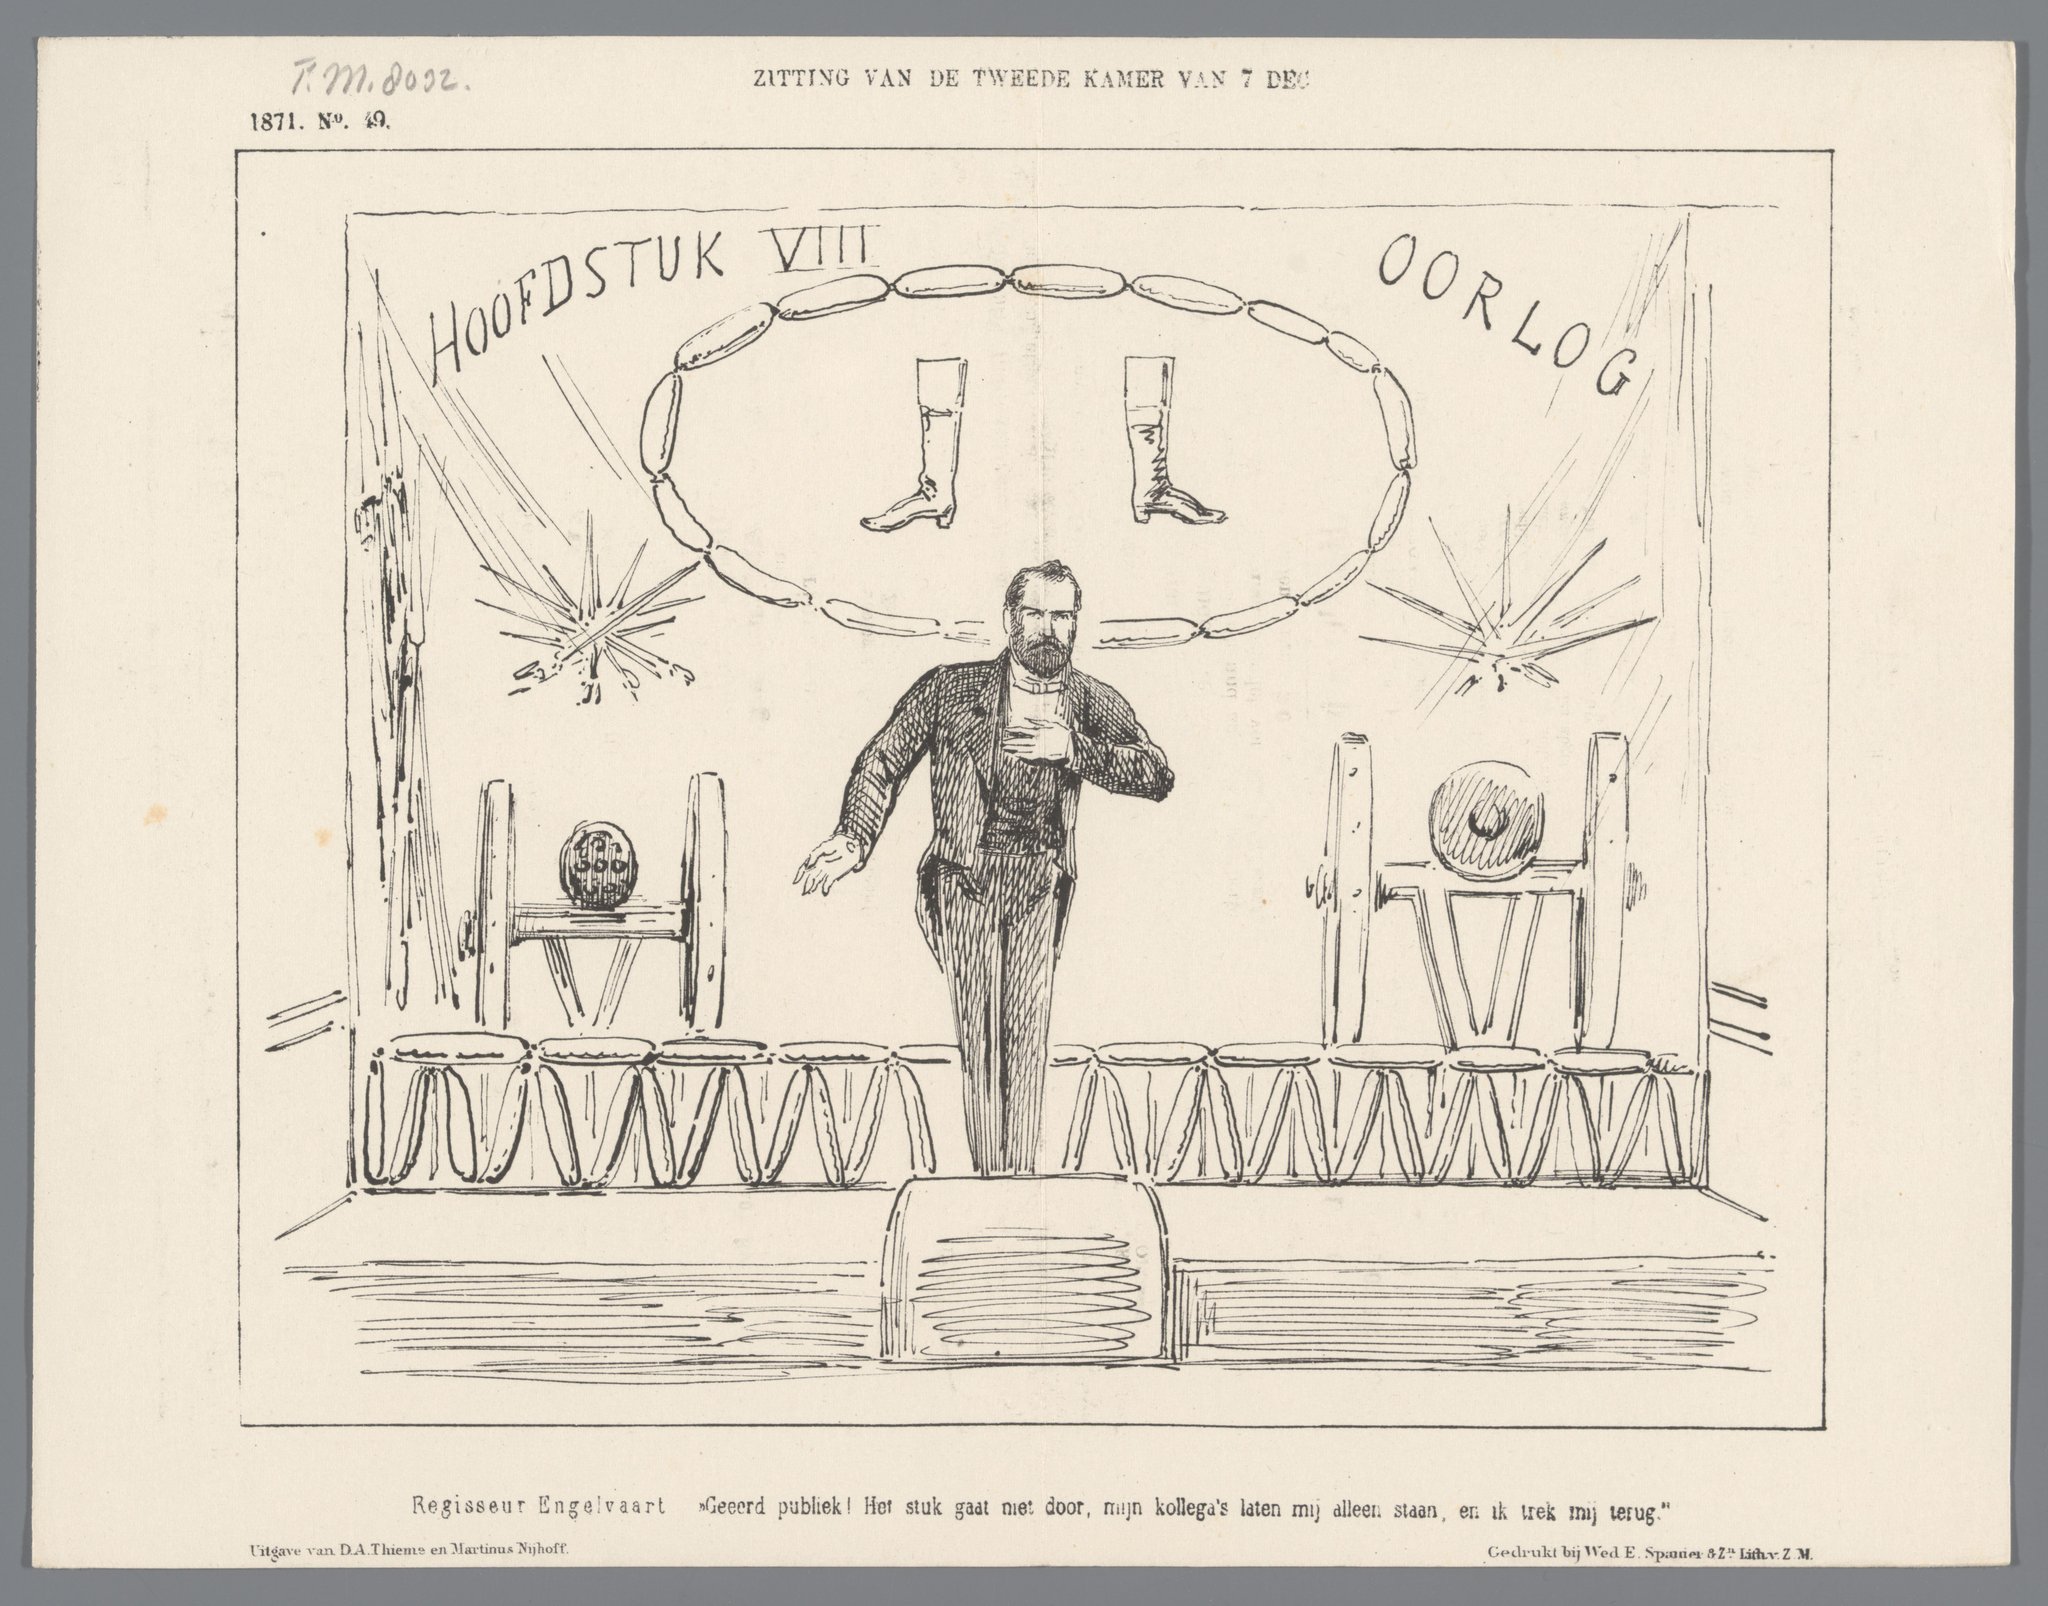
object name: cartoon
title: Spotprent op het ontslag van minister Engelvaart, 1871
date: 1871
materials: paper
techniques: lithograph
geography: the hague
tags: director, producer ~ the stage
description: Spotprent op het ontslag van Minister van Oorlog Engelvaart tijdens de behandeling van de begroting. Engelvaart vertelt op het toneel aan het publiek dat het toneelstuk niet doorgaat. Plaat verschenen bij het weekblad De Nederlandsche Spectator, nr. 49, 1871.